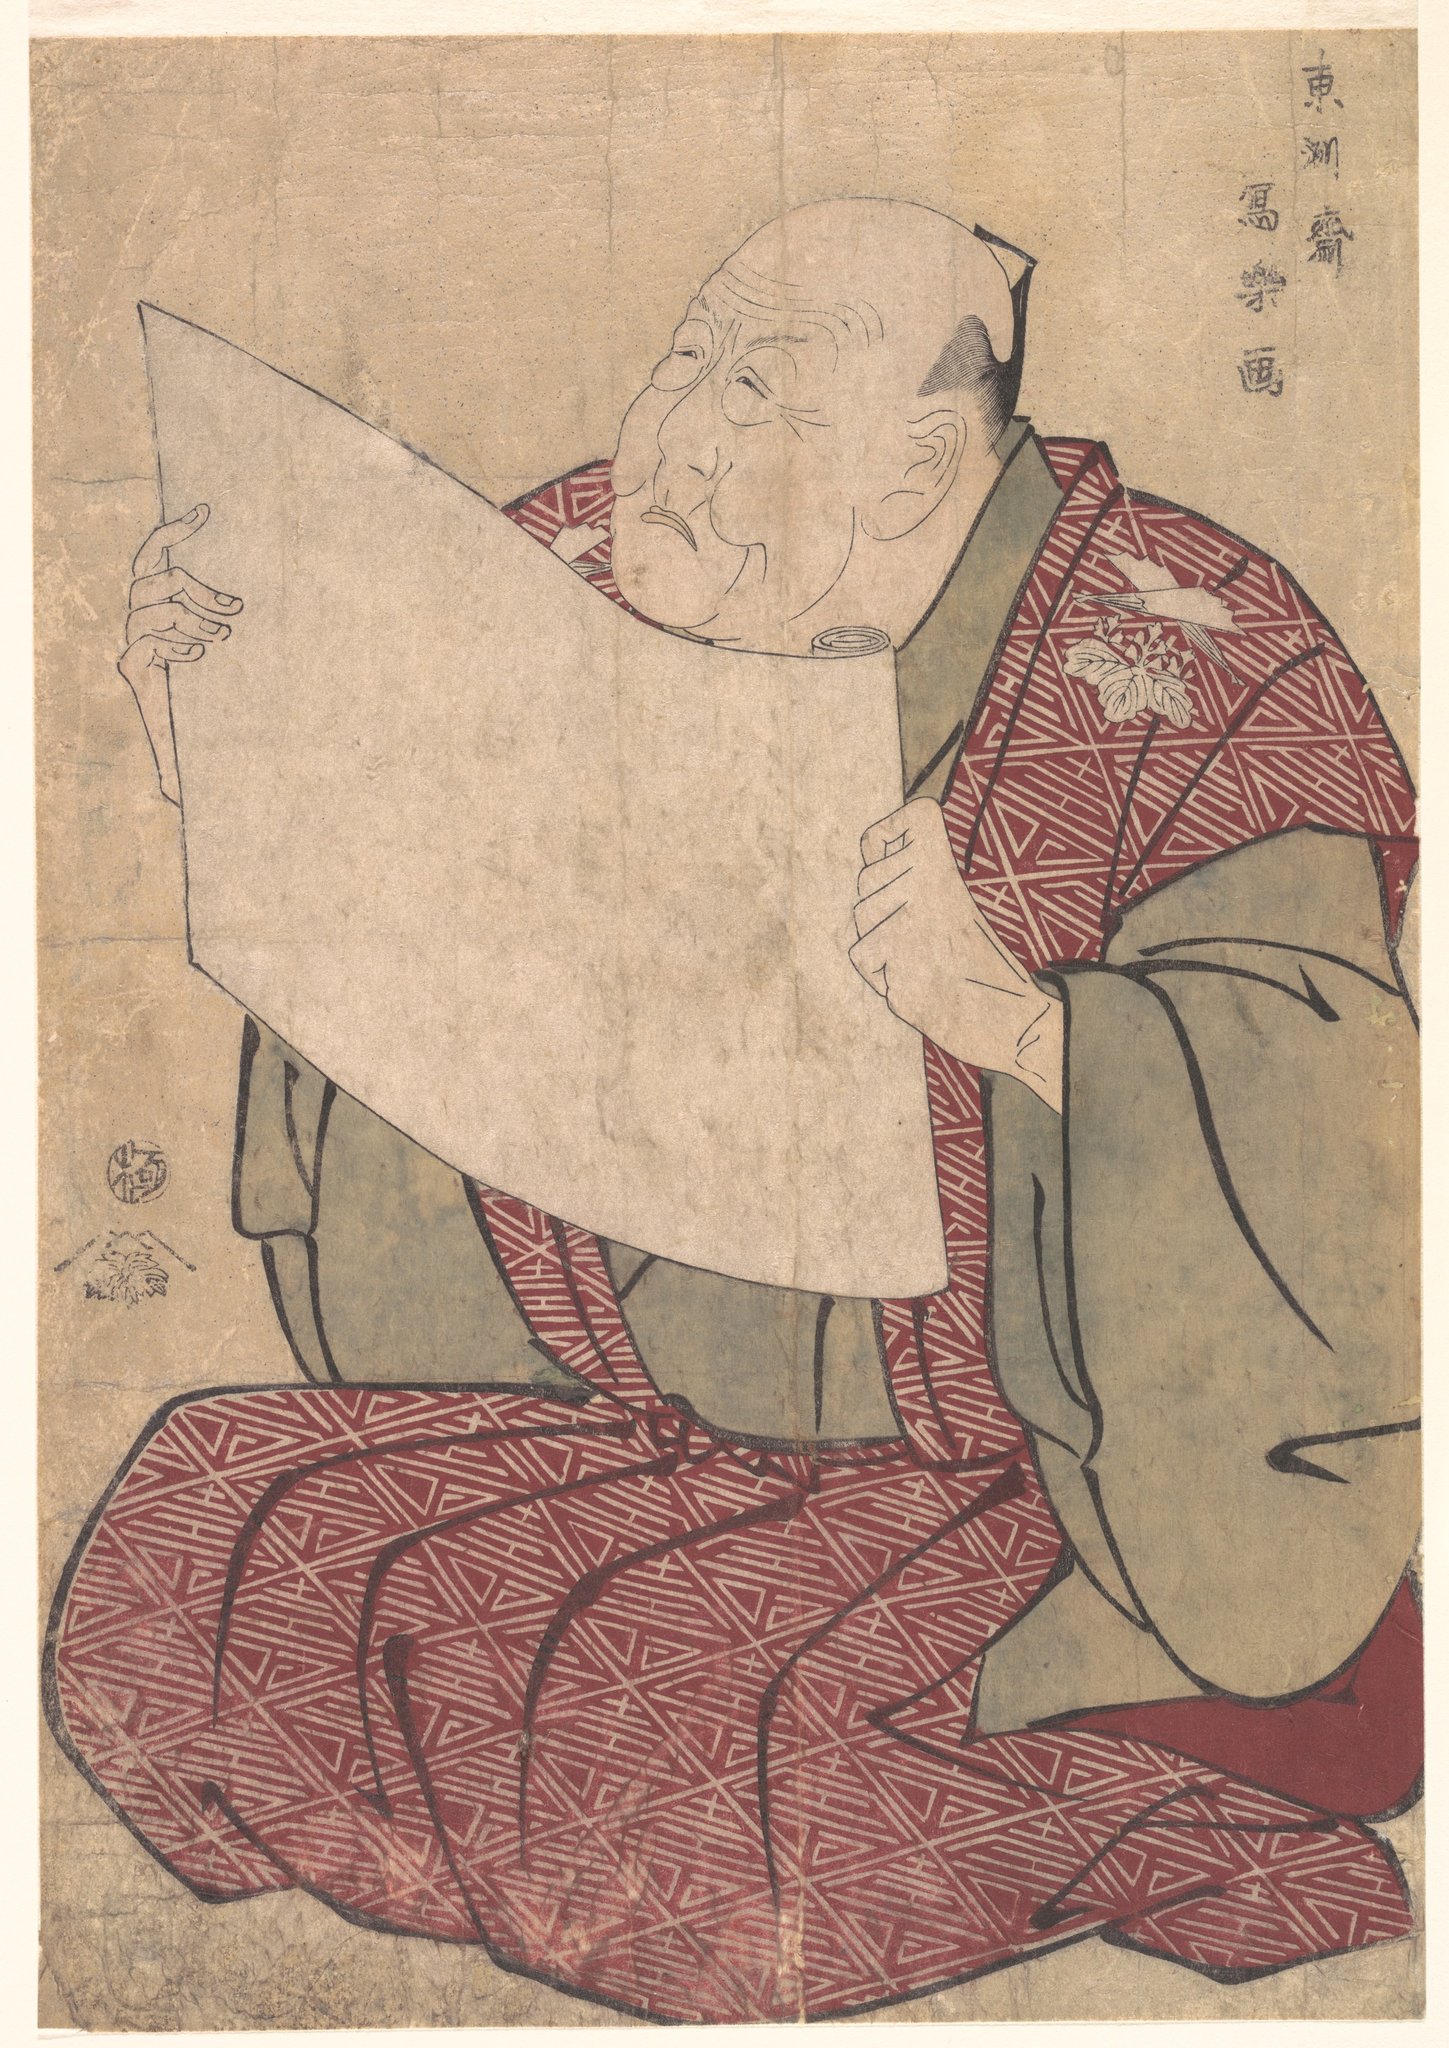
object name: print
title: Miyako Dennai III, the Stage Manager of the Metropolitan Theater (Miyako-za)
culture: japanese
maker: tōshūsai sharaku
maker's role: artist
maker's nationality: japanese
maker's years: 1794-1795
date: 1794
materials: ink, mica, paper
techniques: woodblock print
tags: men,reading